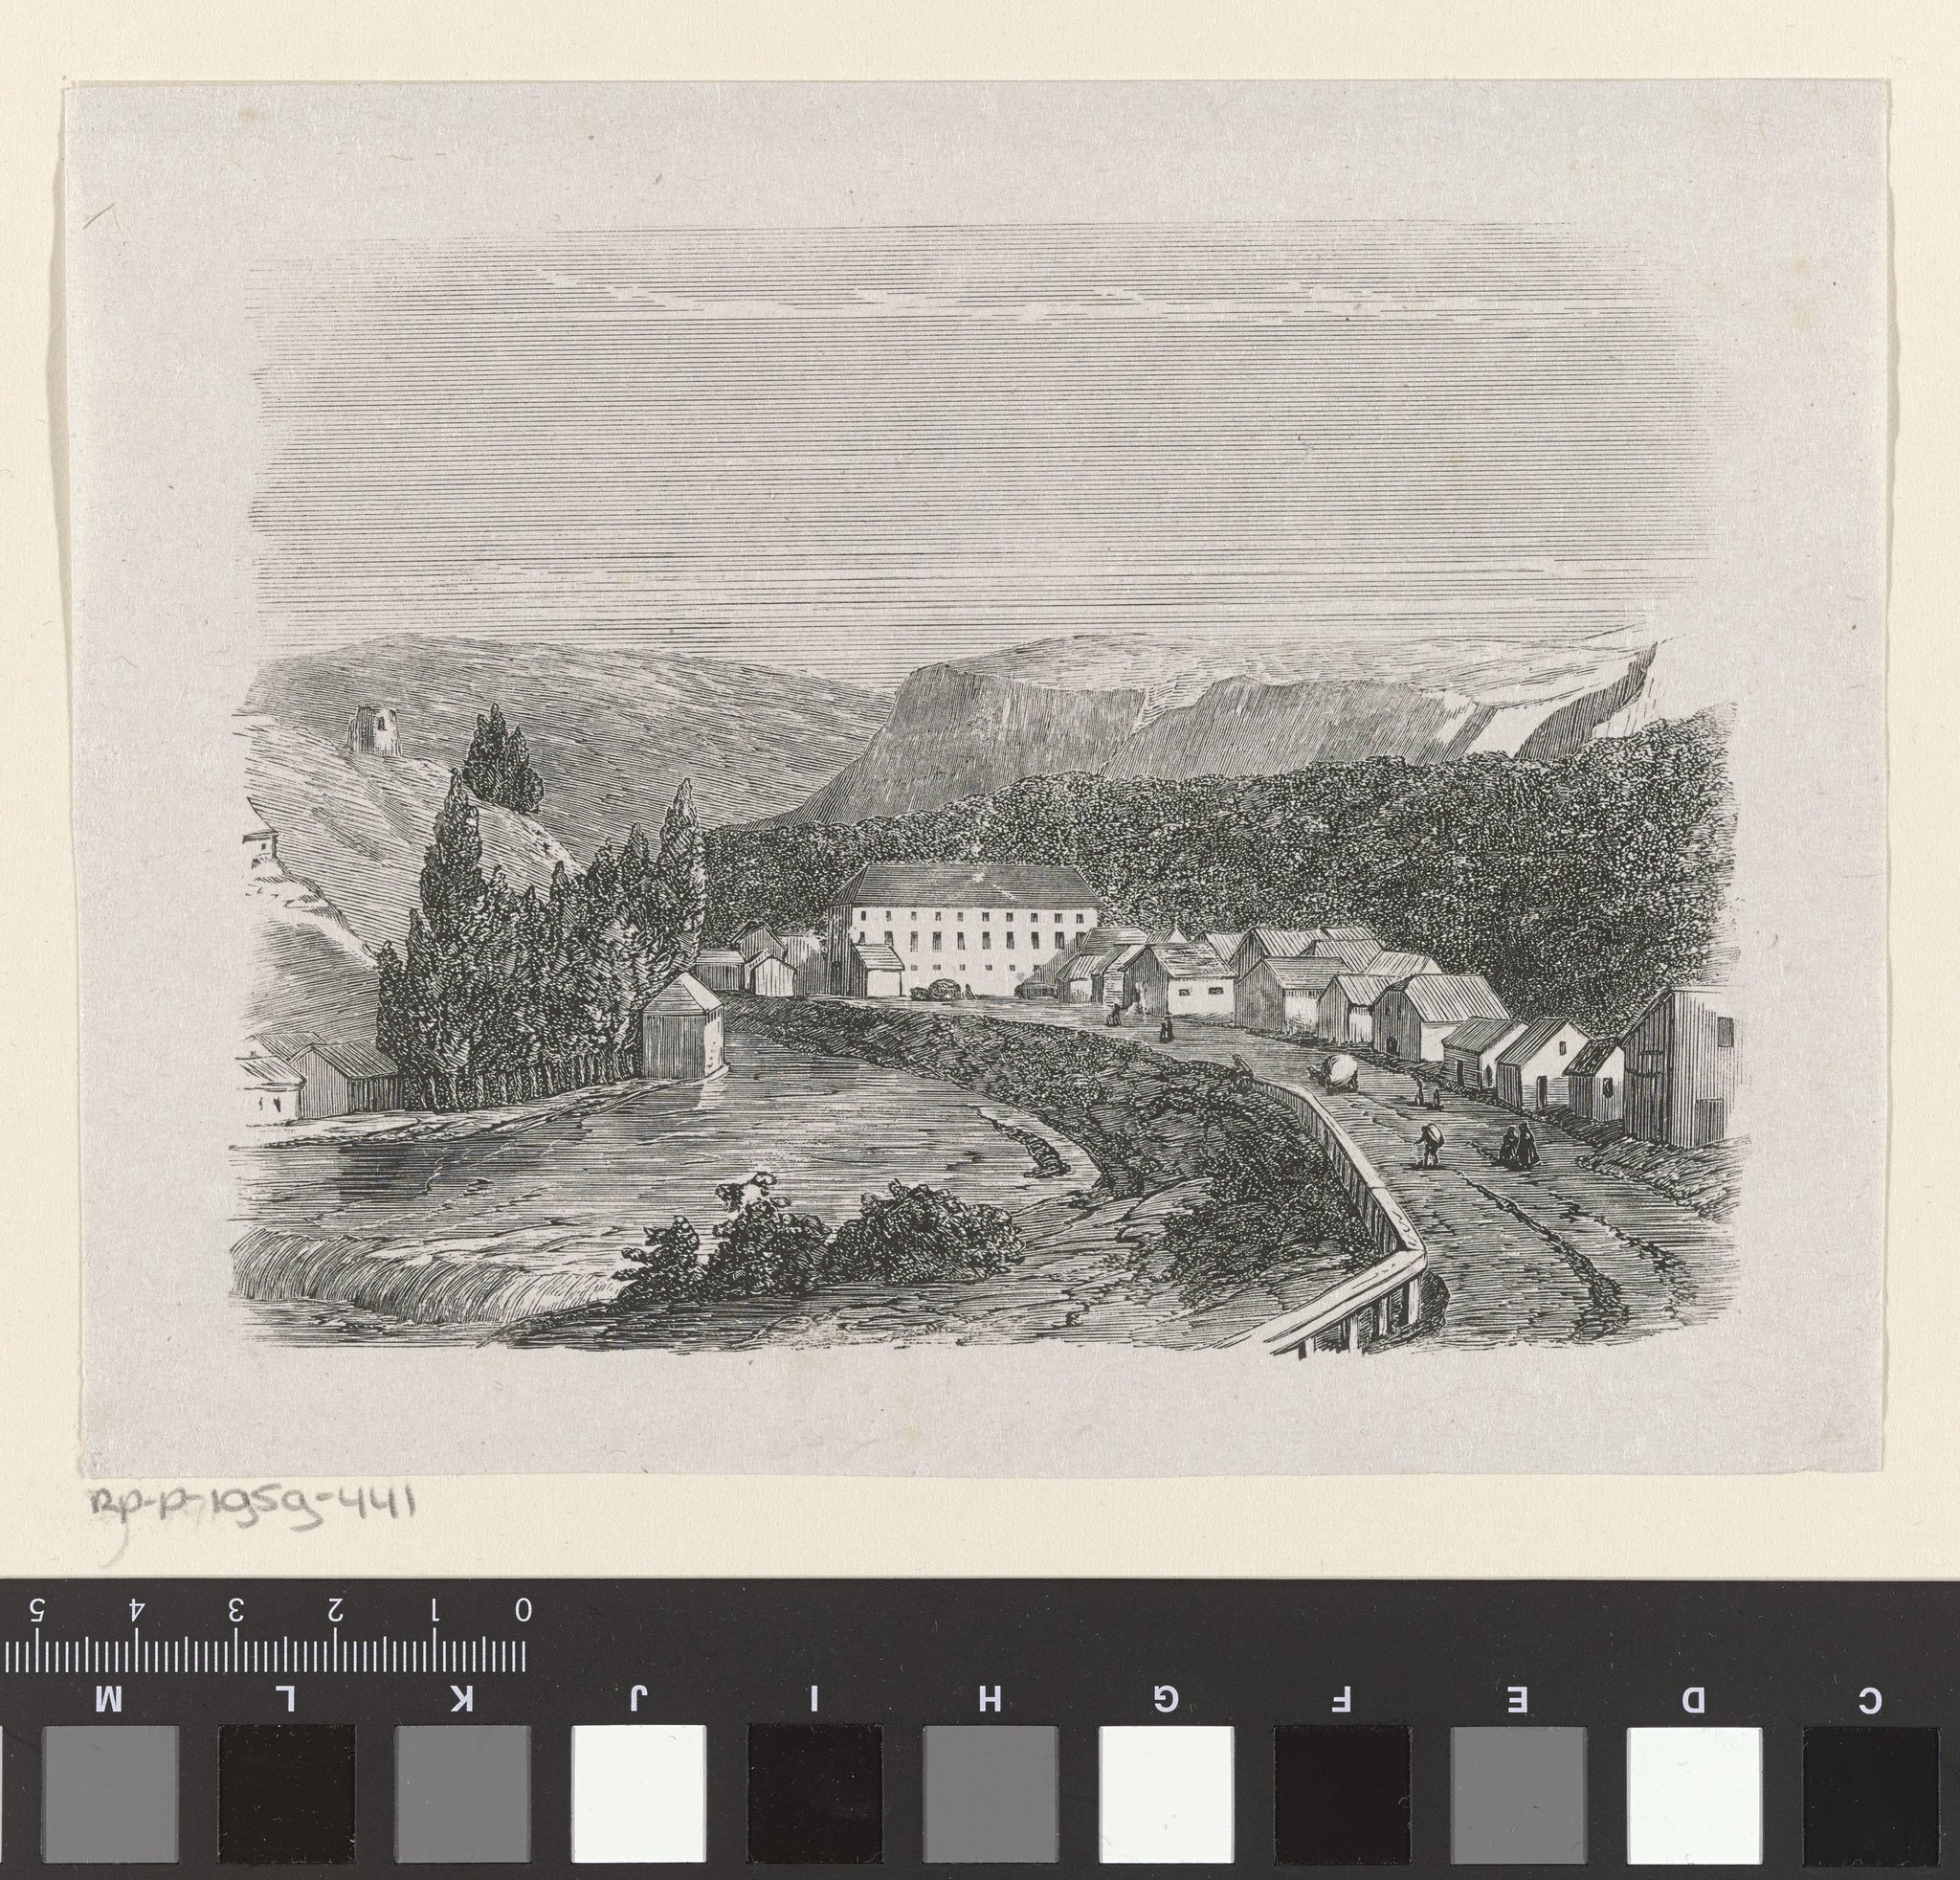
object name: print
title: Rivierlandschap met een dorp in de bergen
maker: isaac weissenbruch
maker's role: print maker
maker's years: 1826-1912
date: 1836-1912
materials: paper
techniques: engraving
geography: netherlands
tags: river, village street (+ city(-scape) with figures, staffage), mountains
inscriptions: collector's mark: Lugt 2228